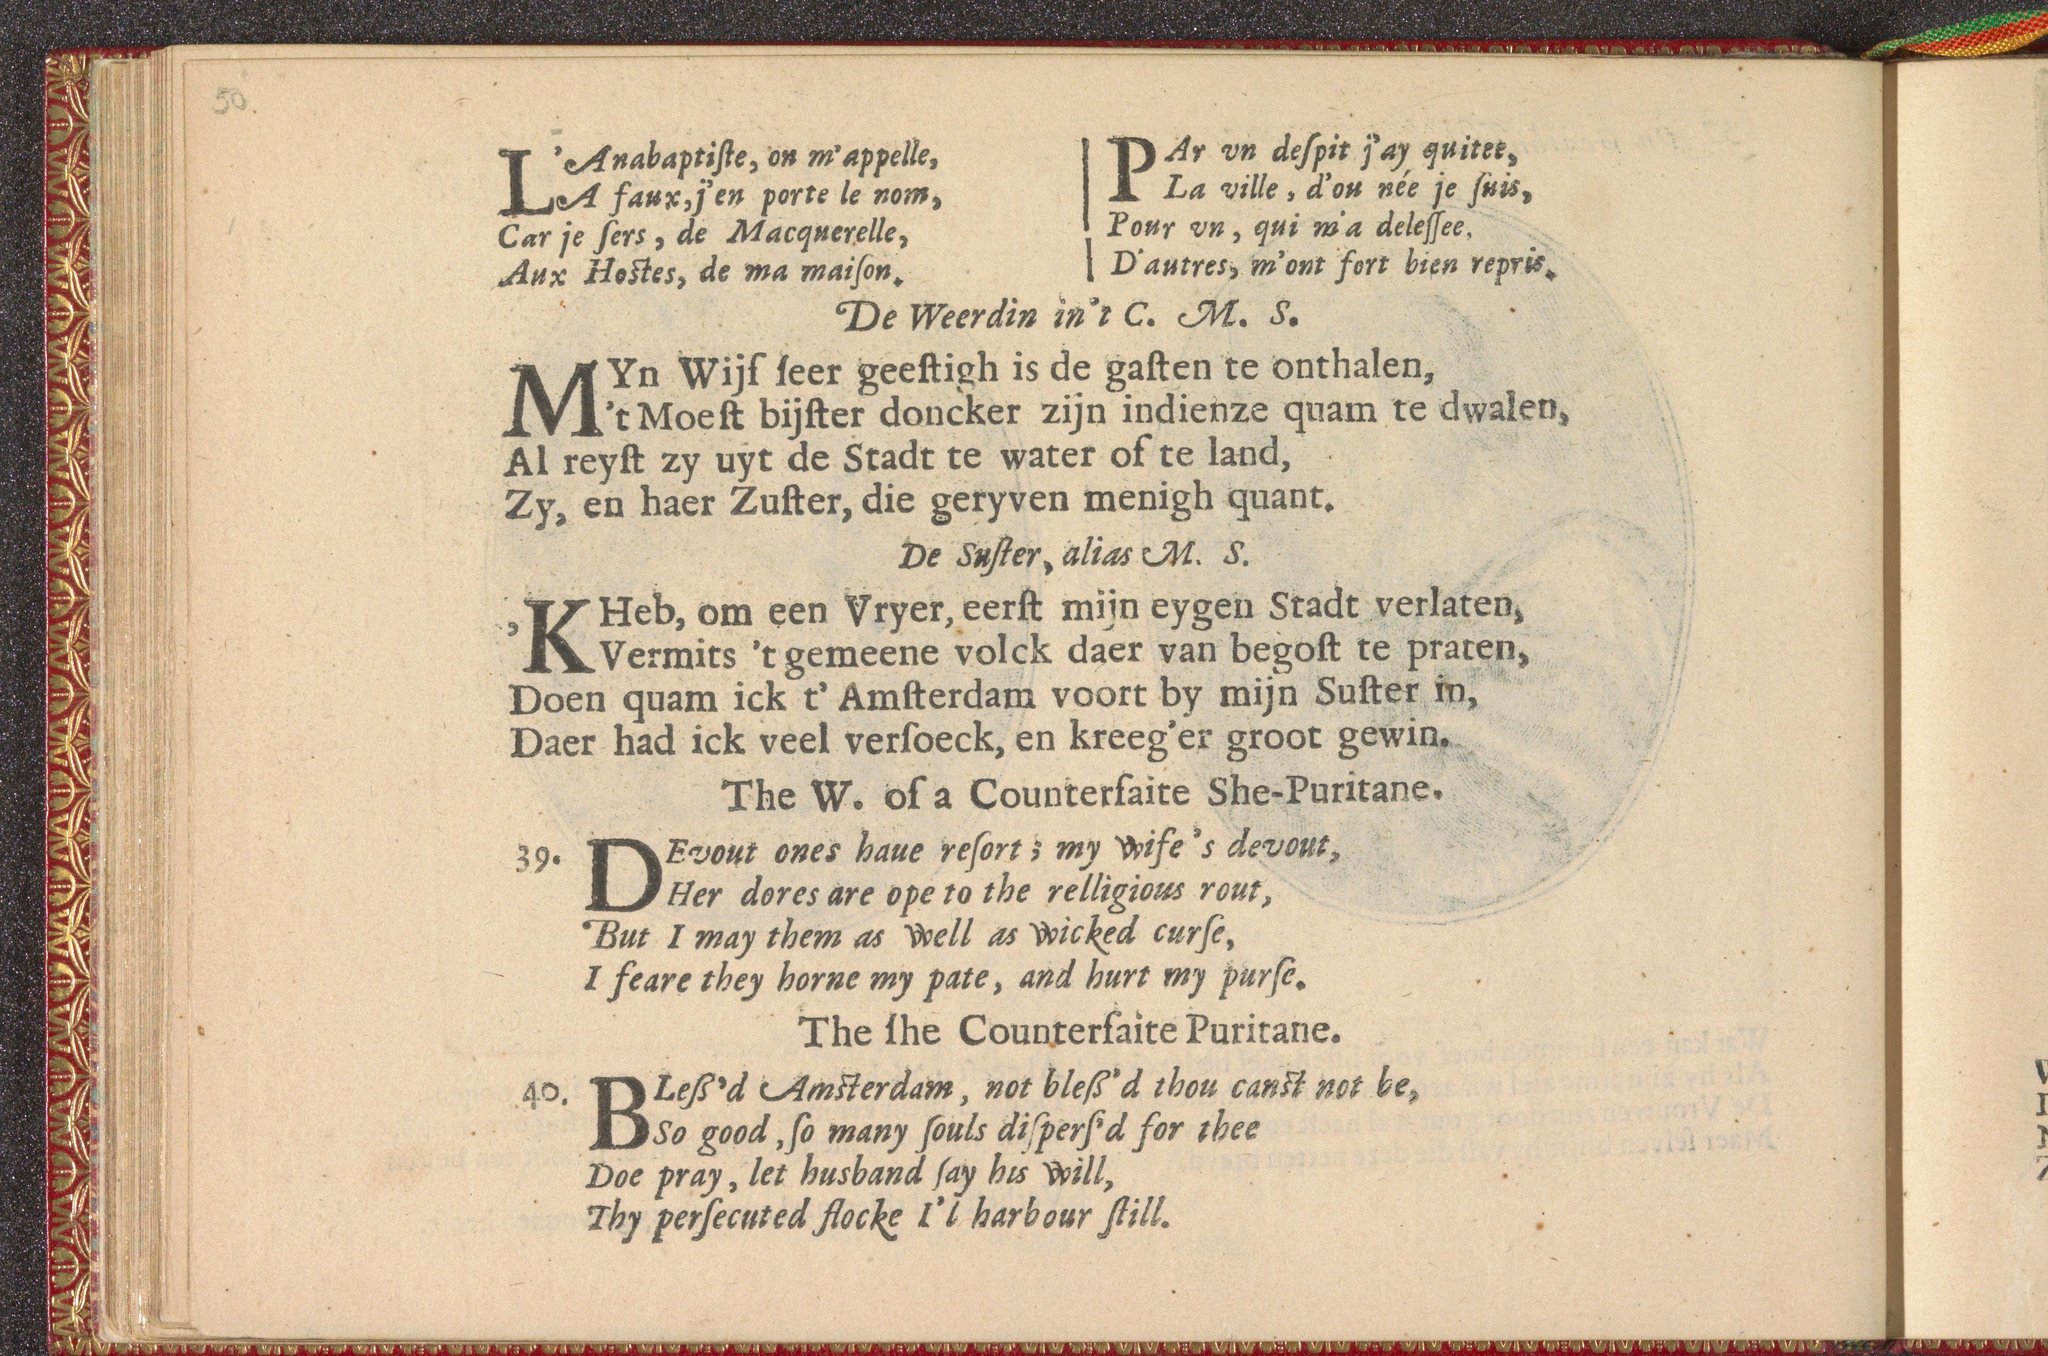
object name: album leaf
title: Les abus du mariage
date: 1641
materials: paper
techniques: letterpress printing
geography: amsterdam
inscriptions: date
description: Drie keer twee kwatrijnen in het Frans, Nederlands en Engels bij voorstellingen van twee mennistenzusjes. Het blad maakt deel uit van een album.